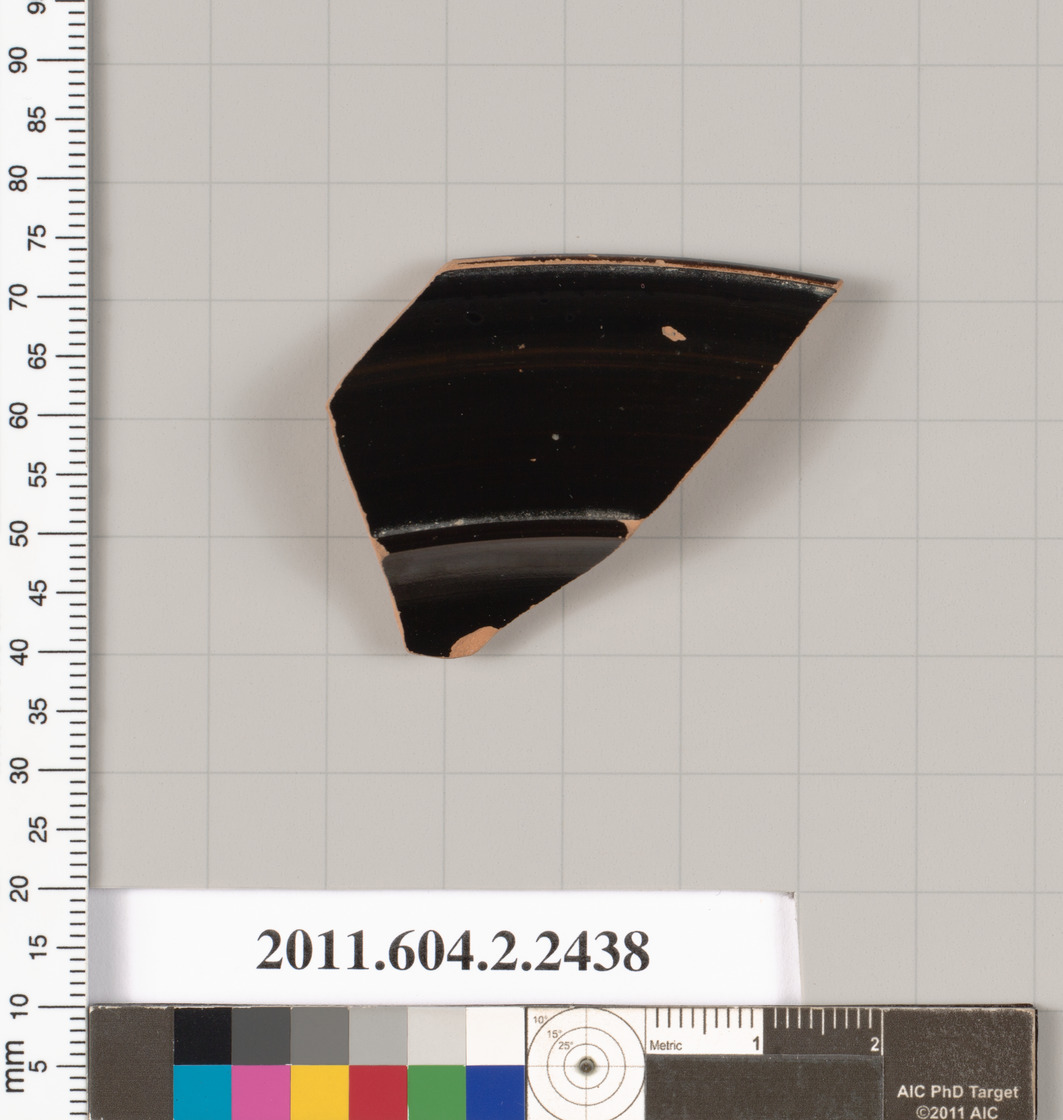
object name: plate fragment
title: Terracotta rim fragment from a plate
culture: greek, attic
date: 520-500 BCE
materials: terracotta